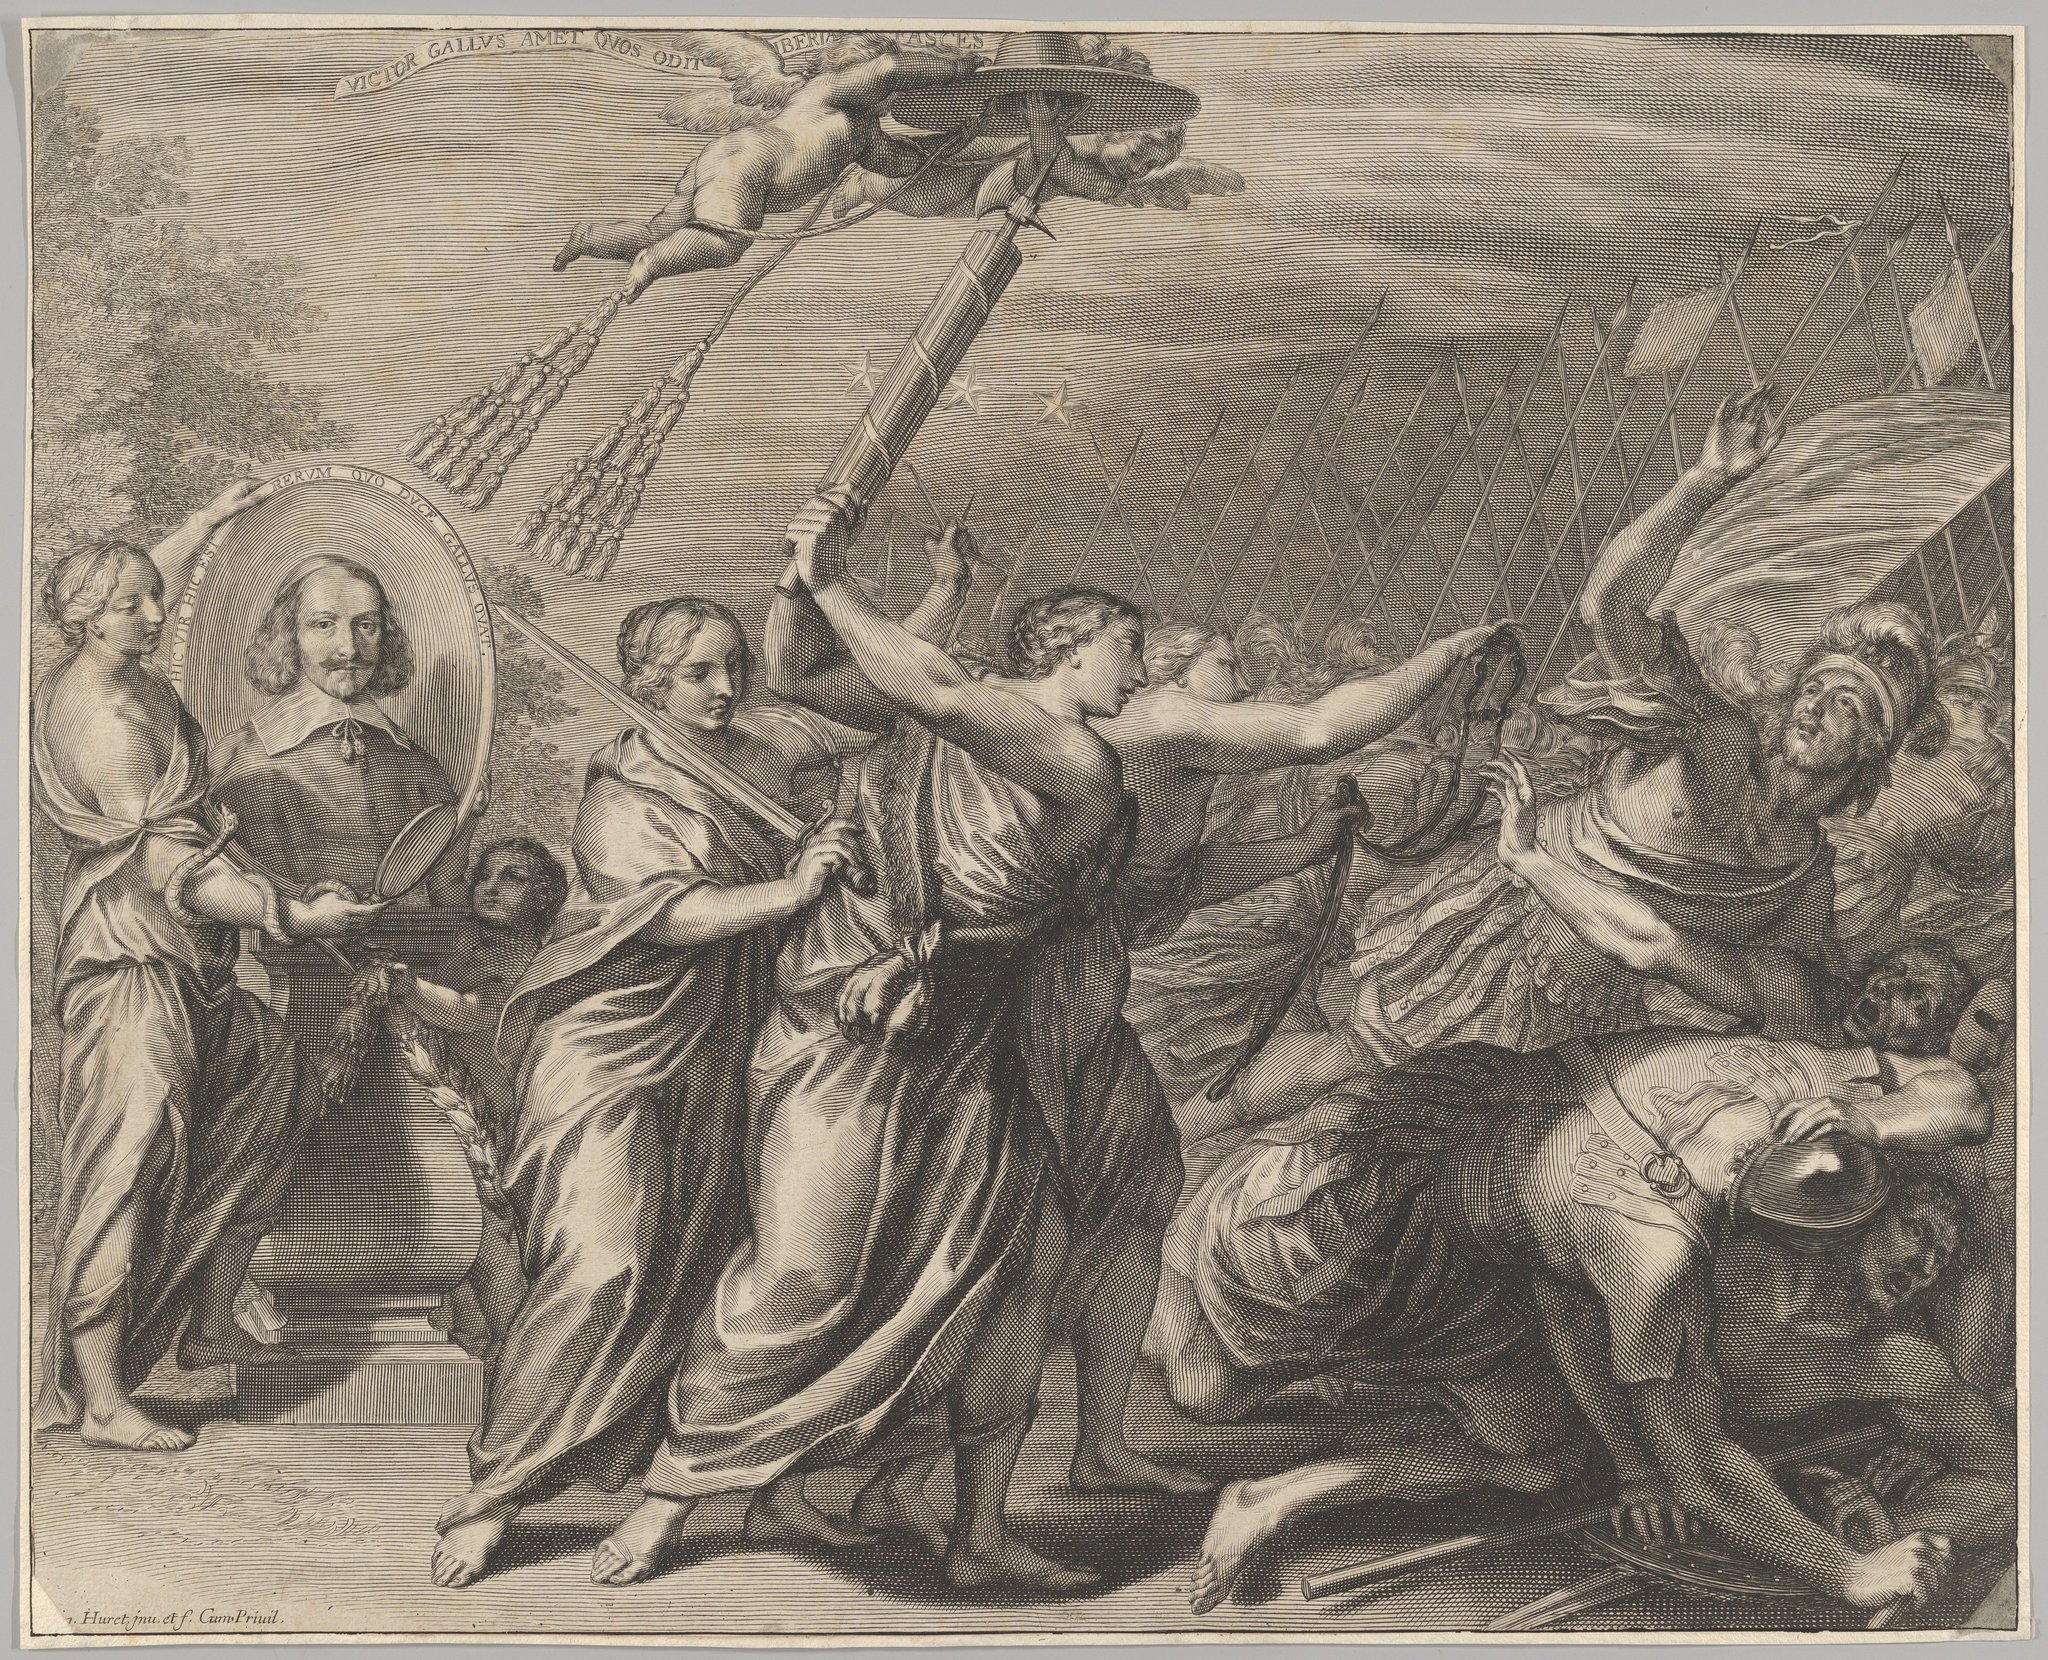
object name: print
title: Cardinal (le Bret?) in oval with allegorigal figures and a battle scene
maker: grégoire huret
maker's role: artist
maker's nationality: french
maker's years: 1606-1670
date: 1601-1700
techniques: engraving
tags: battles,men,women